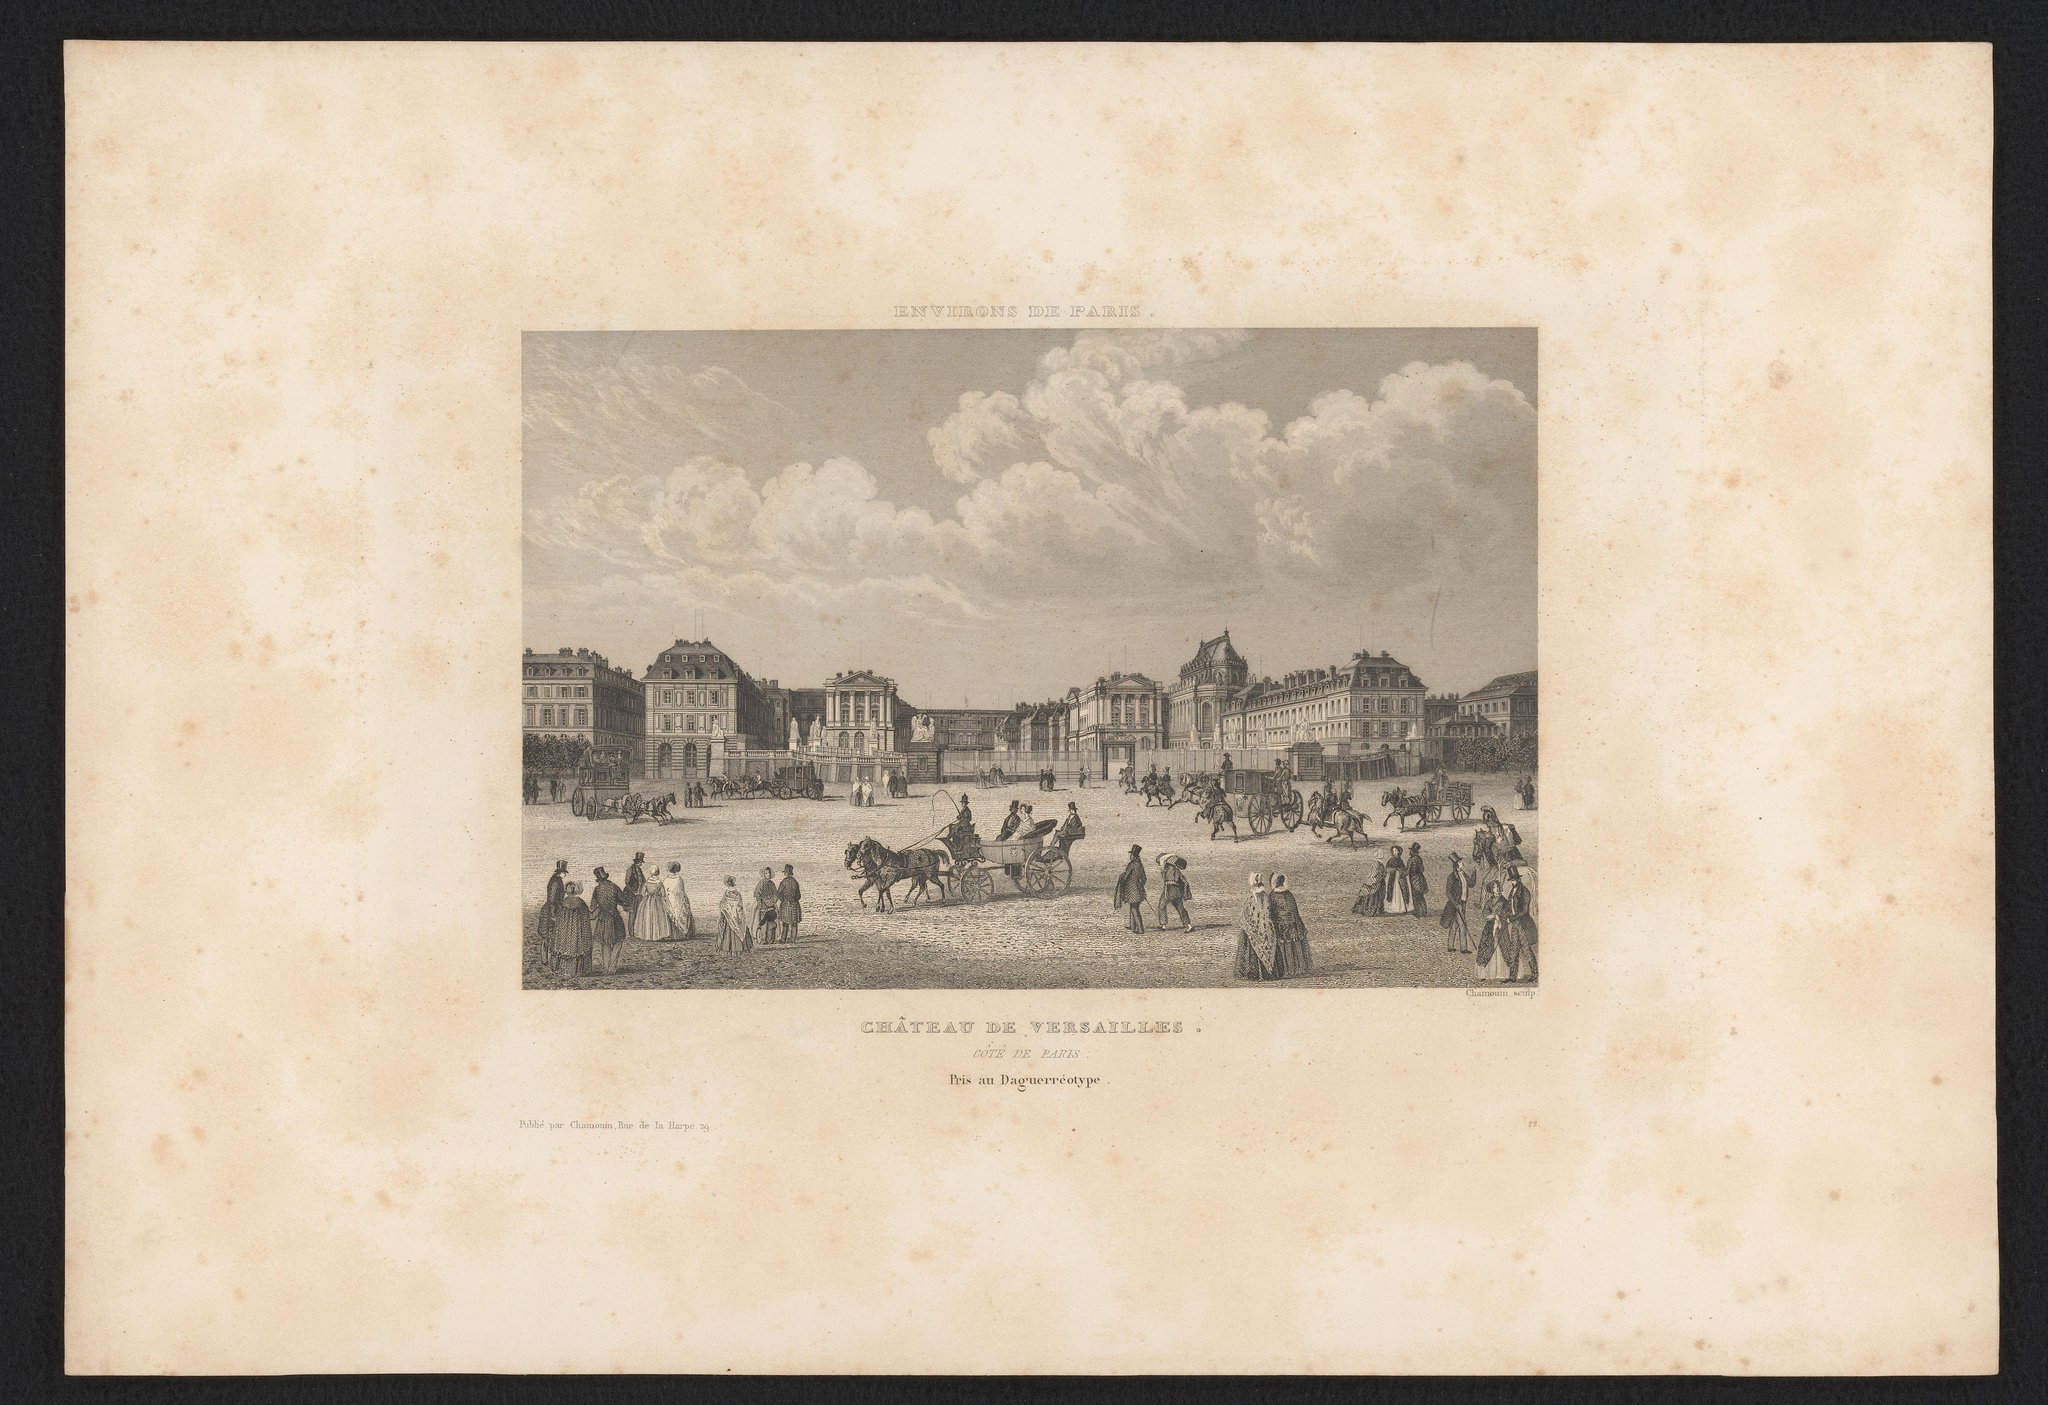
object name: print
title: Vues de Paris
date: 1845-1850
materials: paper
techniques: engraving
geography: paris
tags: palace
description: Deze prent maakt deel uit van een omslag met 22 prenten op 22 bladen.